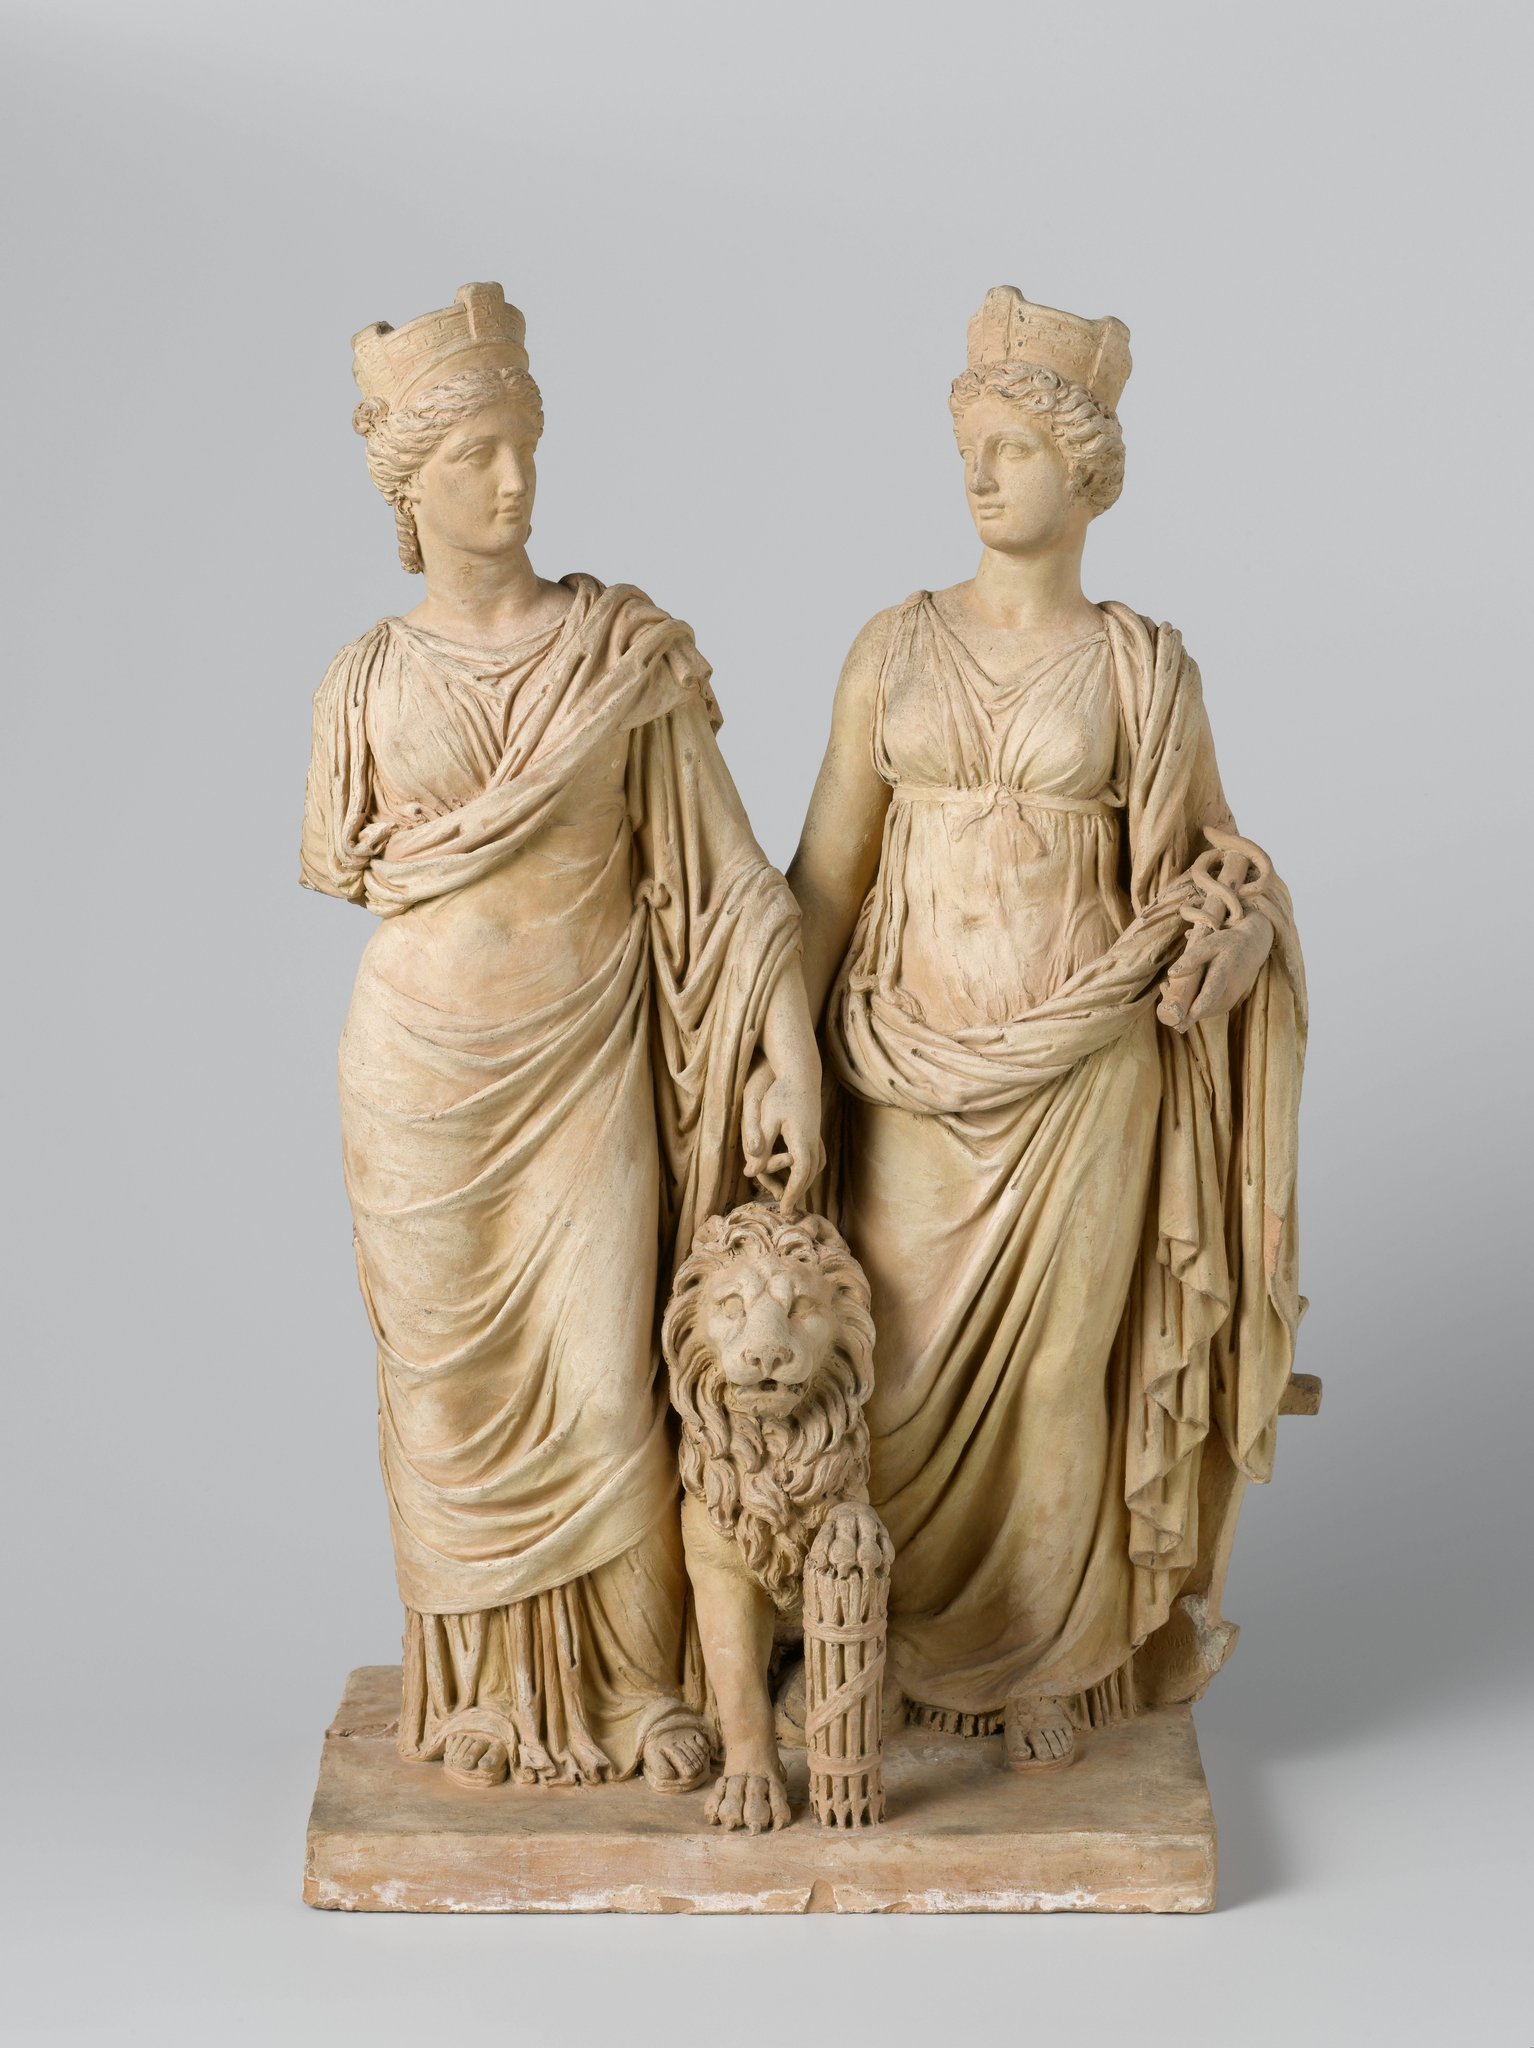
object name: figure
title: Allegory of the United Kingdom of the Netherlands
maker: jean-louis van geel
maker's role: sculptor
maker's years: 1787-1852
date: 1816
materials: terracotta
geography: brussels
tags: personifications of countries, nations, states, districts, etc. (+ nation; national), beasts of prey, predatory animals: lion (+ heraldic animals)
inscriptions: signature and date: ‘L, van [...] 1816’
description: Terracotta groep met twee allegorische vrouwenfiguren in antieke kleding die elkaars hand vasthouden. De rechterfiguur heeft een Mercuriusstaf in haar hand en een ploeg aan haar zijde. De linkerfiguur mist haar rechterarm, waardoor haar identificerende attributen ontbreken. Beide vrouwen dragen een kroon. In het midden staat een leeuw met fasces.